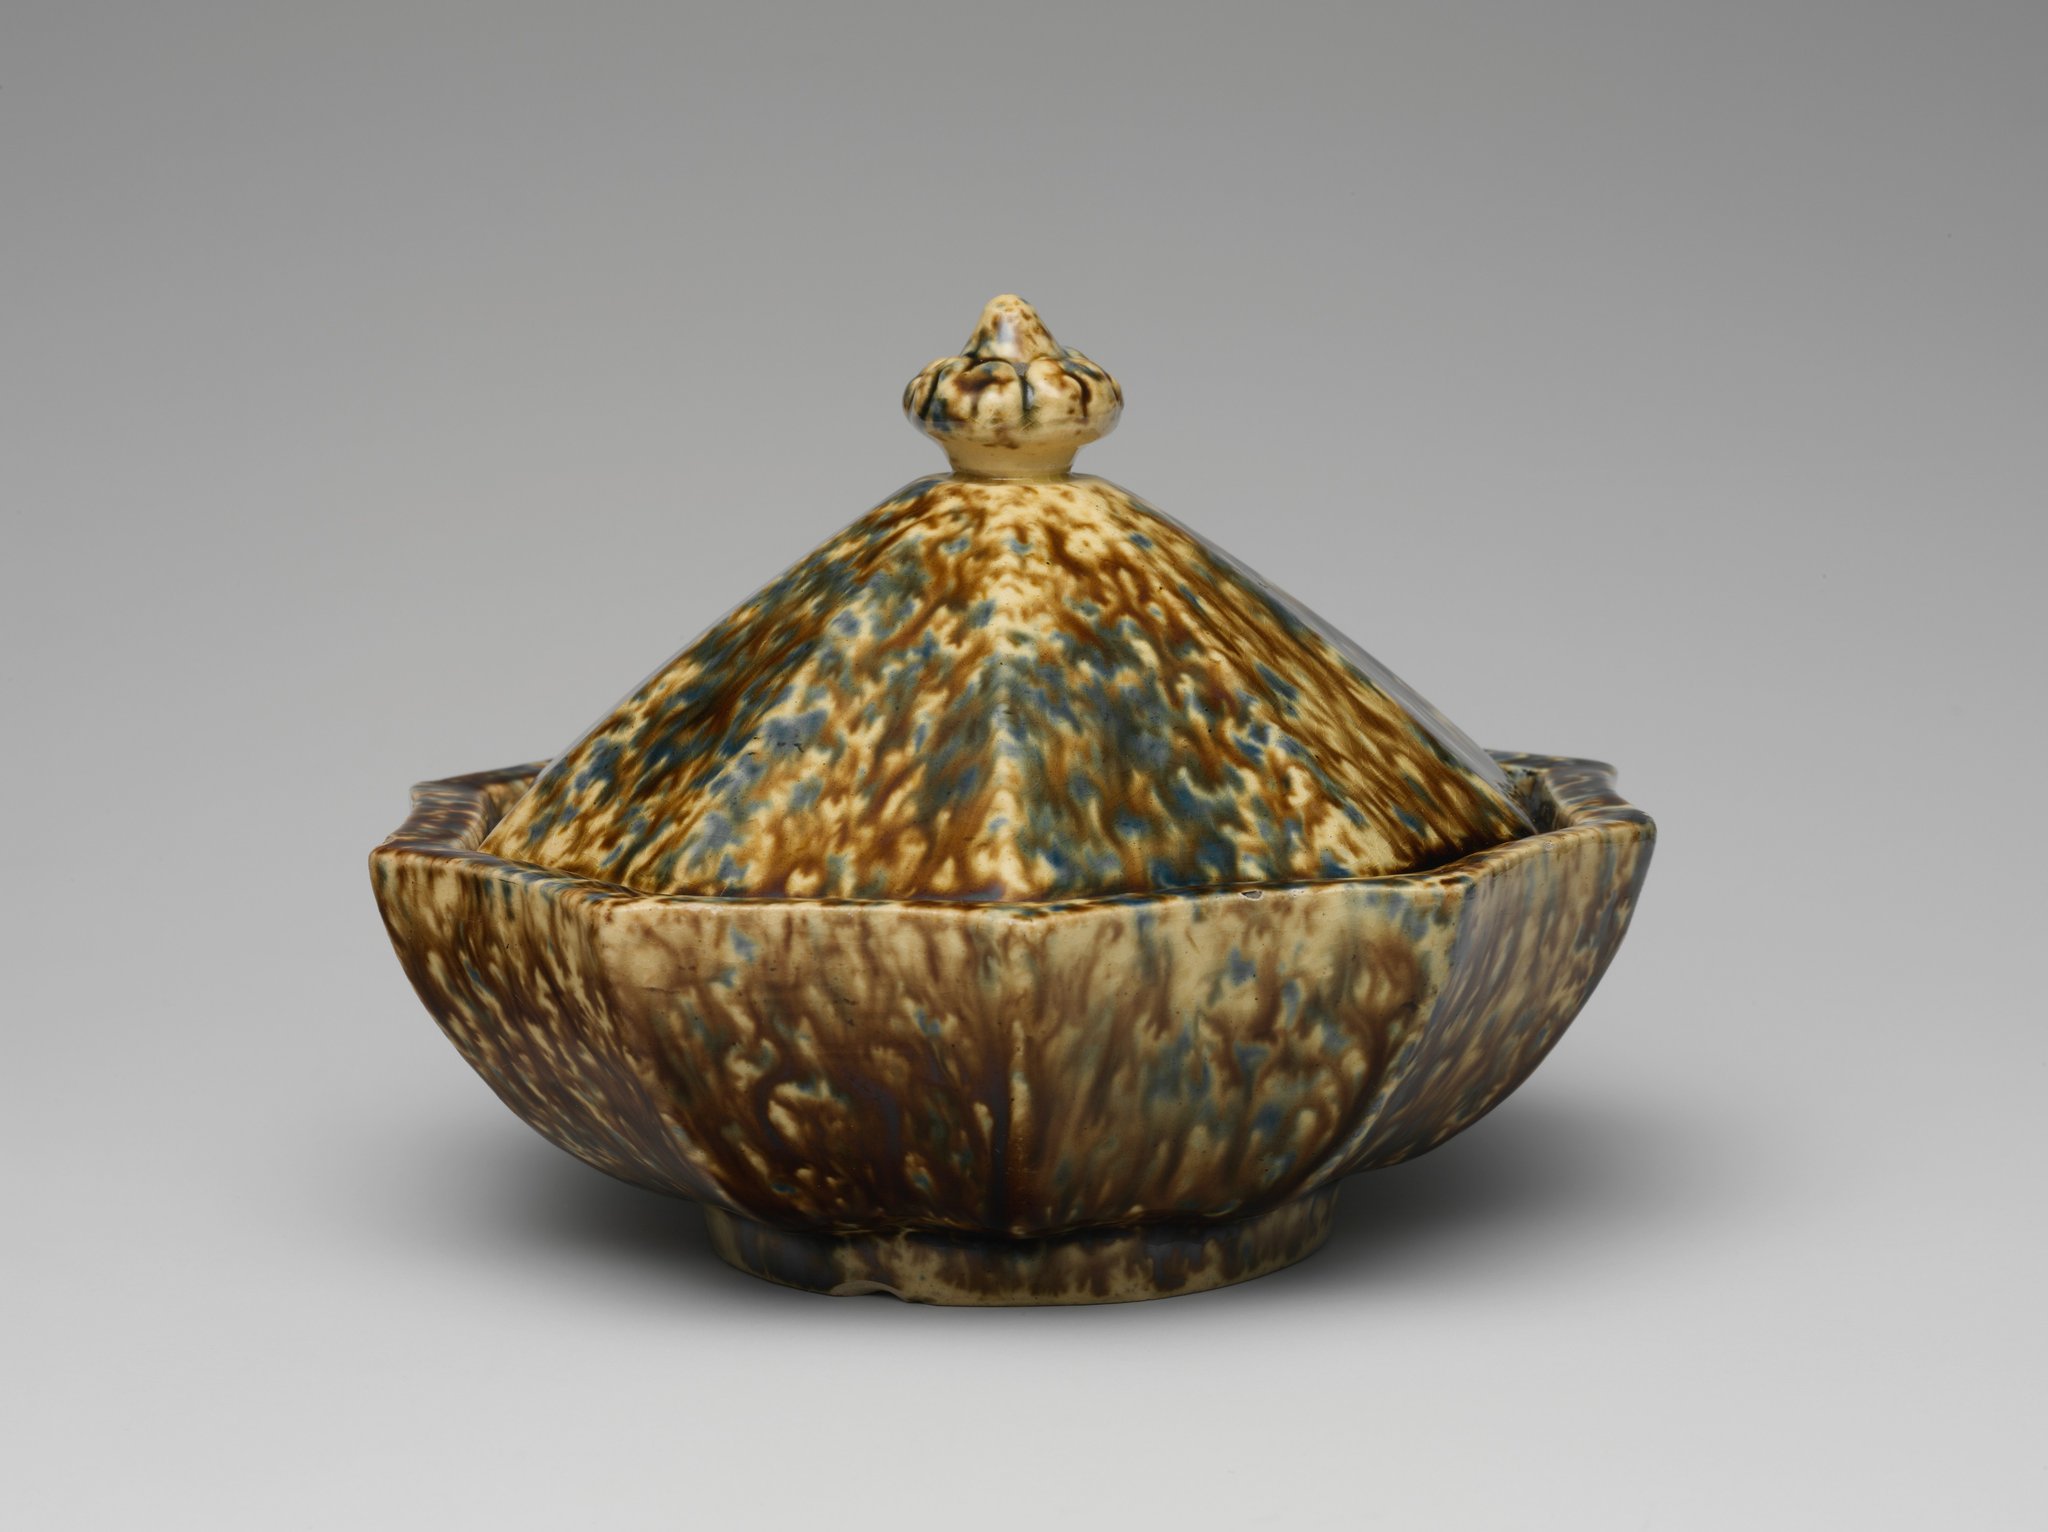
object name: dish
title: Covered dish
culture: american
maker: ralph bagnall beech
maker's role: maker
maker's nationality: american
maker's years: 1845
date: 1851-1857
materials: earthenware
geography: united states